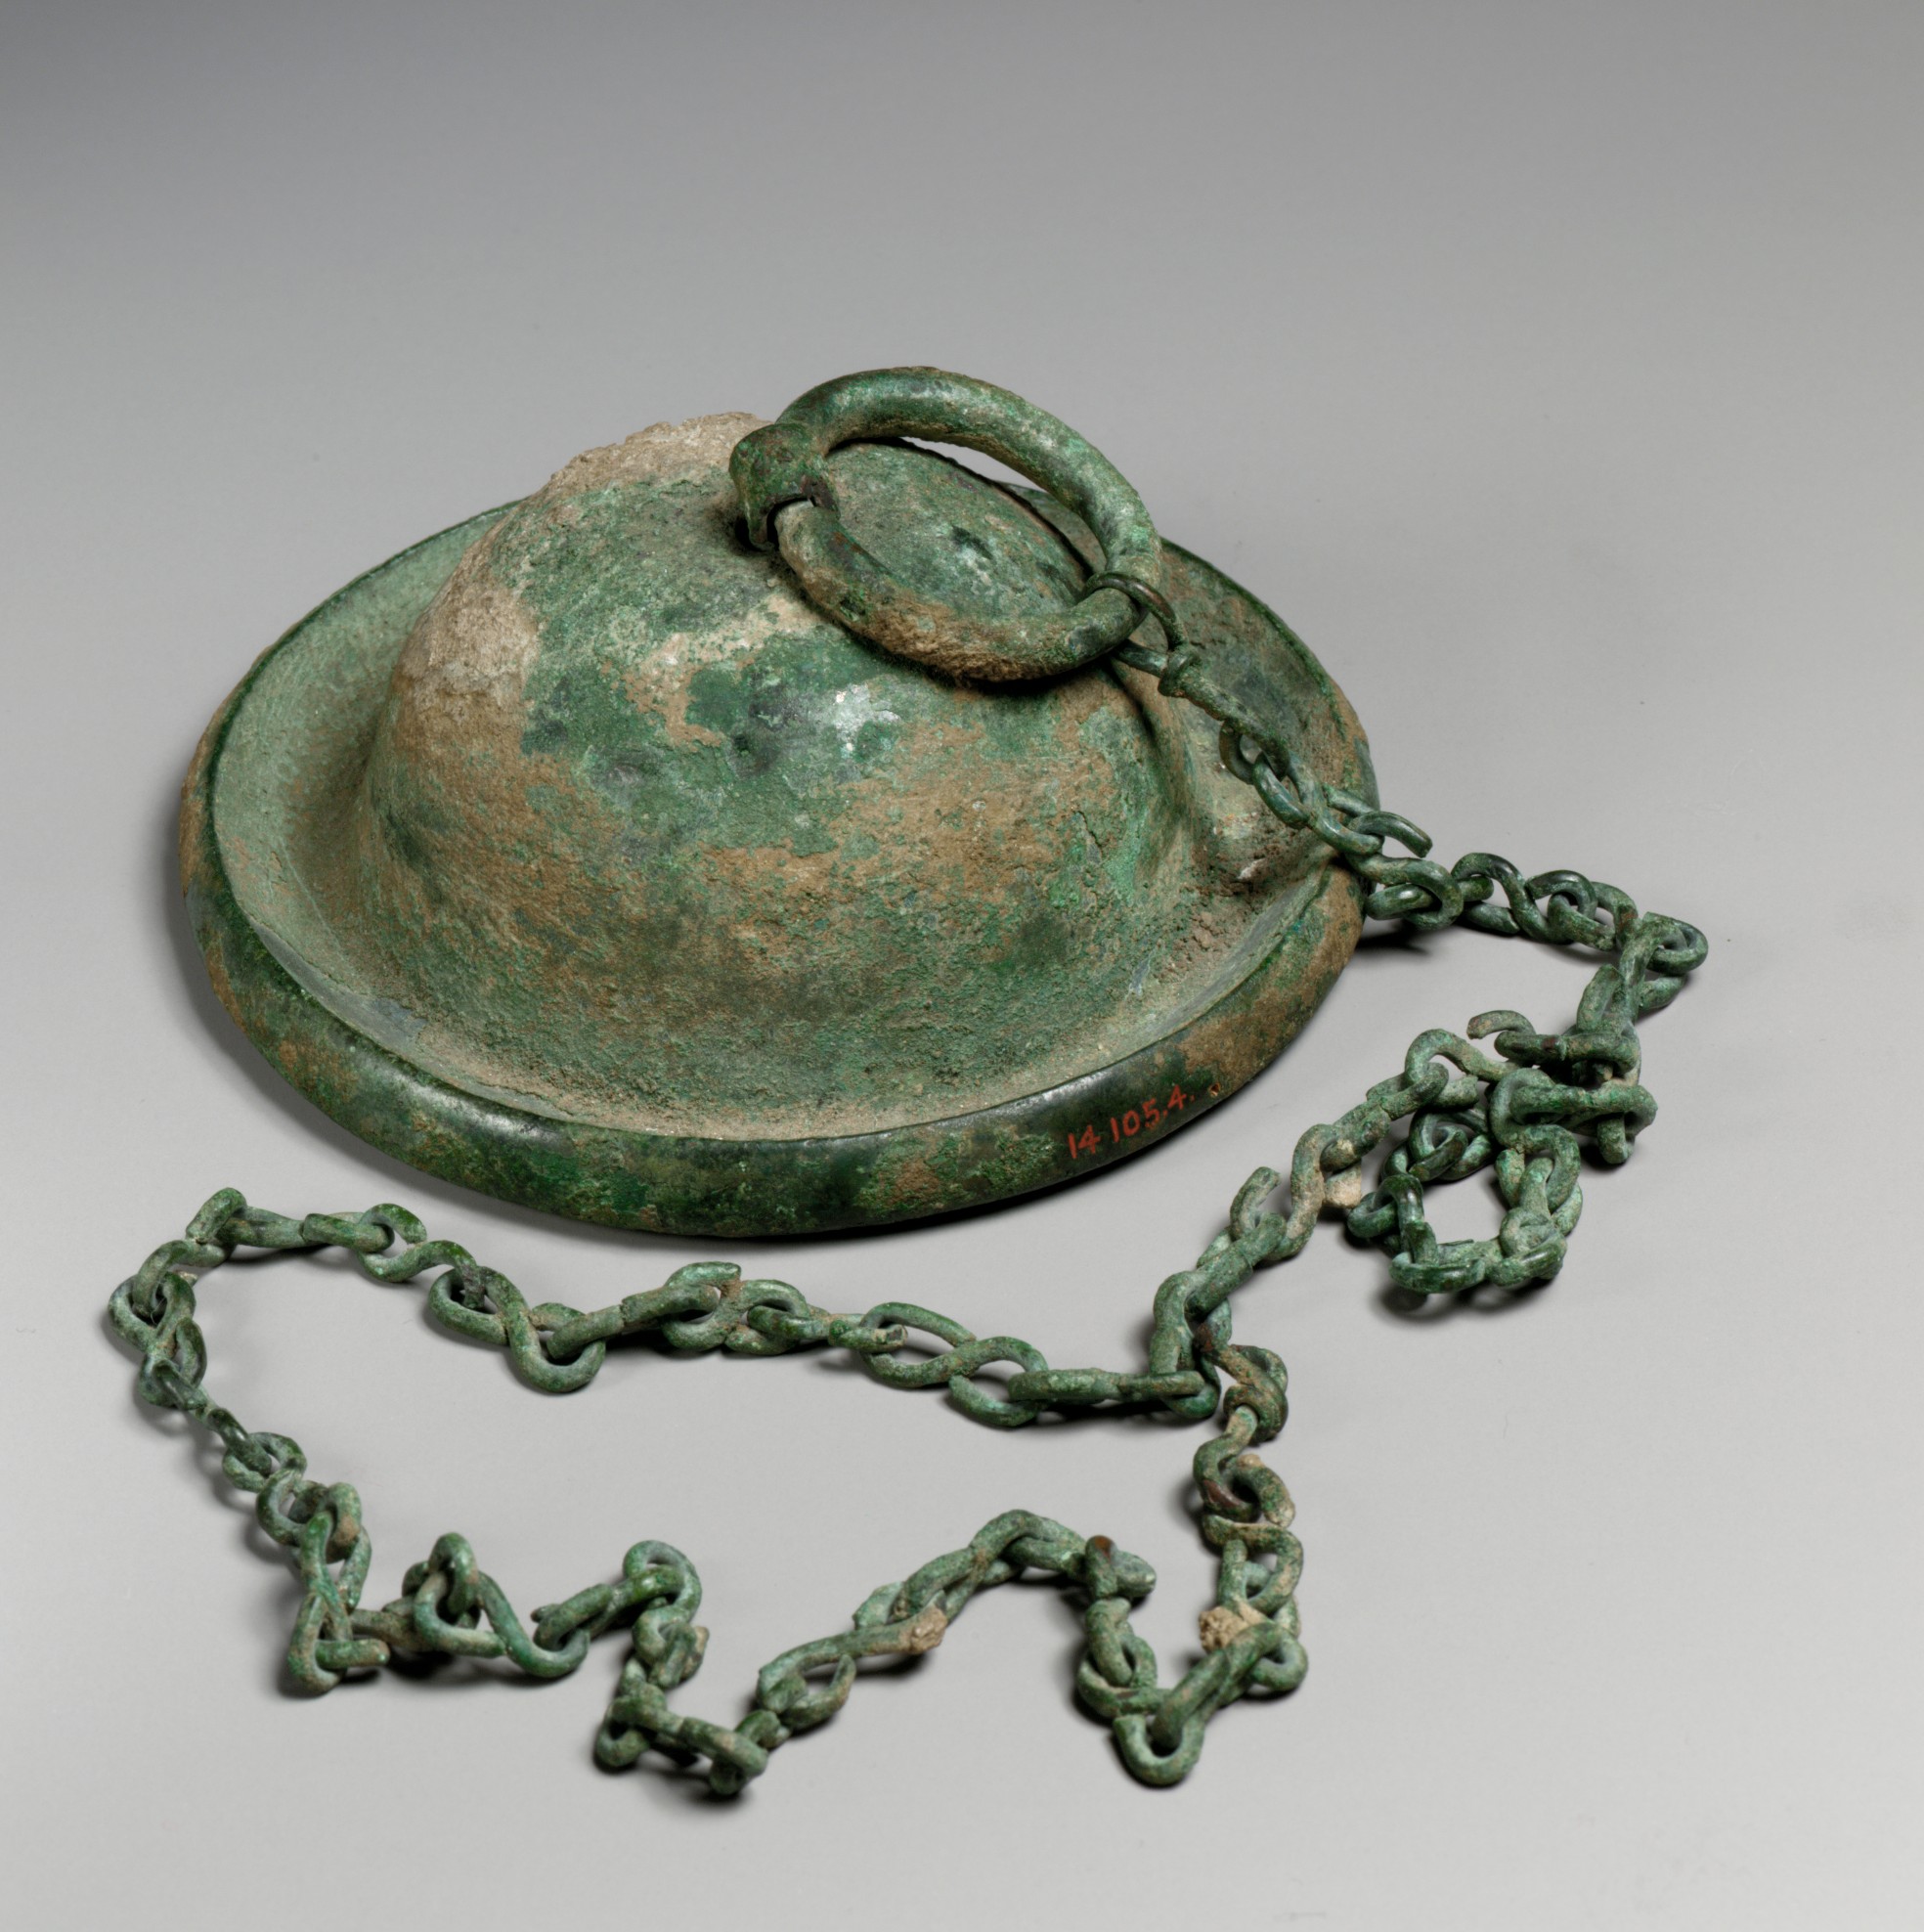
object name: cymbal with chain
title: Cymbals with chain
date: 7000 BCE-330 CE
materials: bronze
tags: musical instruments